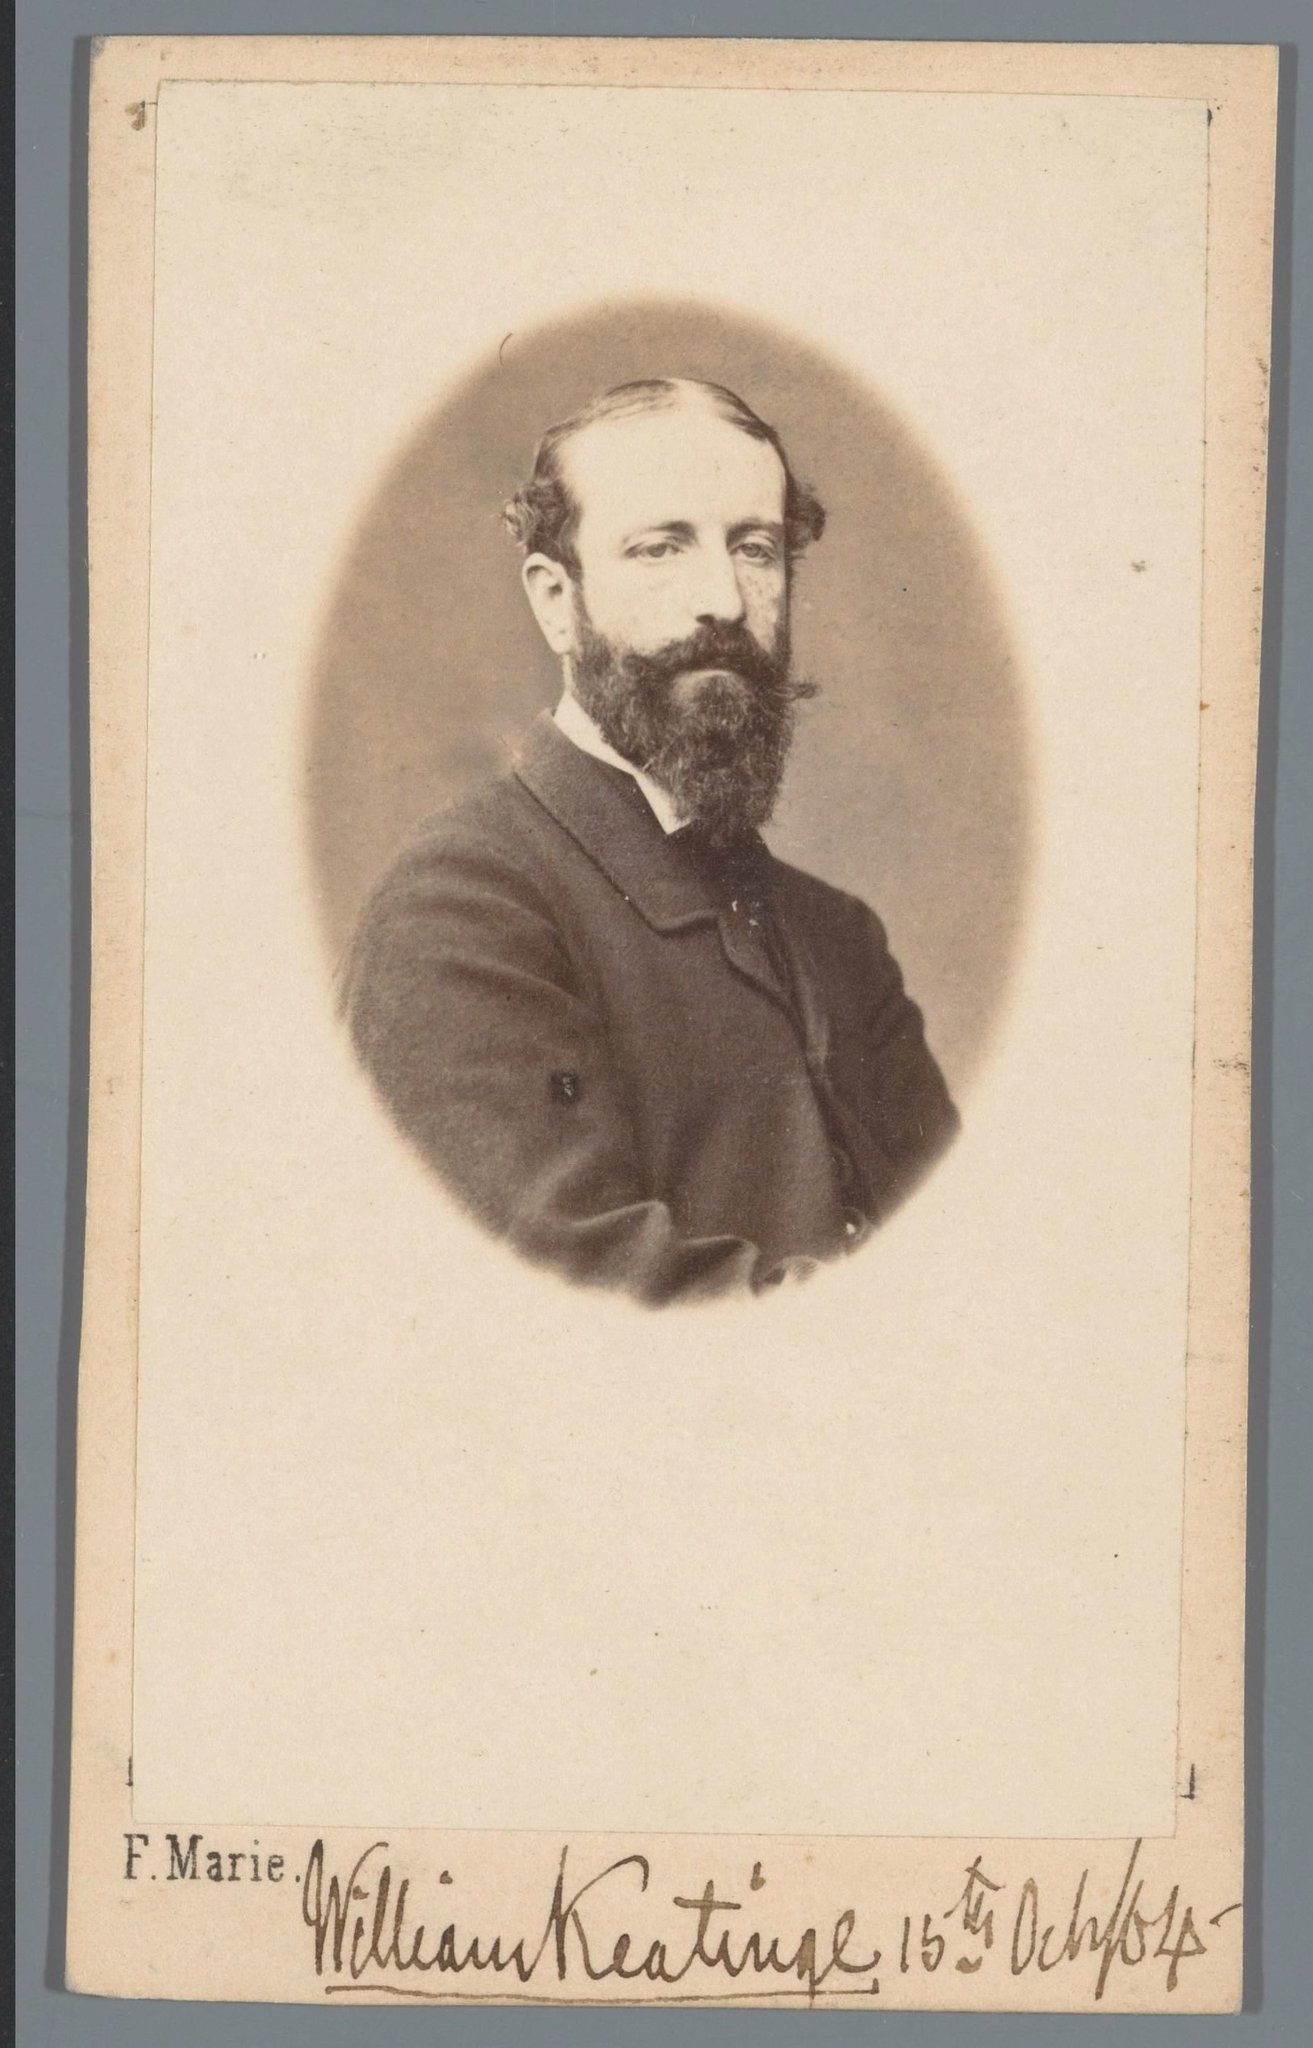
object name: photograph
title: Portret van William Keatinge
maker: françois marie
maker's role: painter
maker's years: 1826-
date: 1864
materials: cardboard, paper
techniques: albumen print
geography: rennes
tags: adult man, historical persons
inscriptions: inscription: ‘William Keatinge, 15th Octr/64’, inscription: ‘Wm. Keatinge Esqre/ 21 Merrion Square South/ Dublin’, inscription: ‘F. Marie,/ 6 bis, Rue de Belair,/ Rennes.’, inscription: ‘F. Marie’